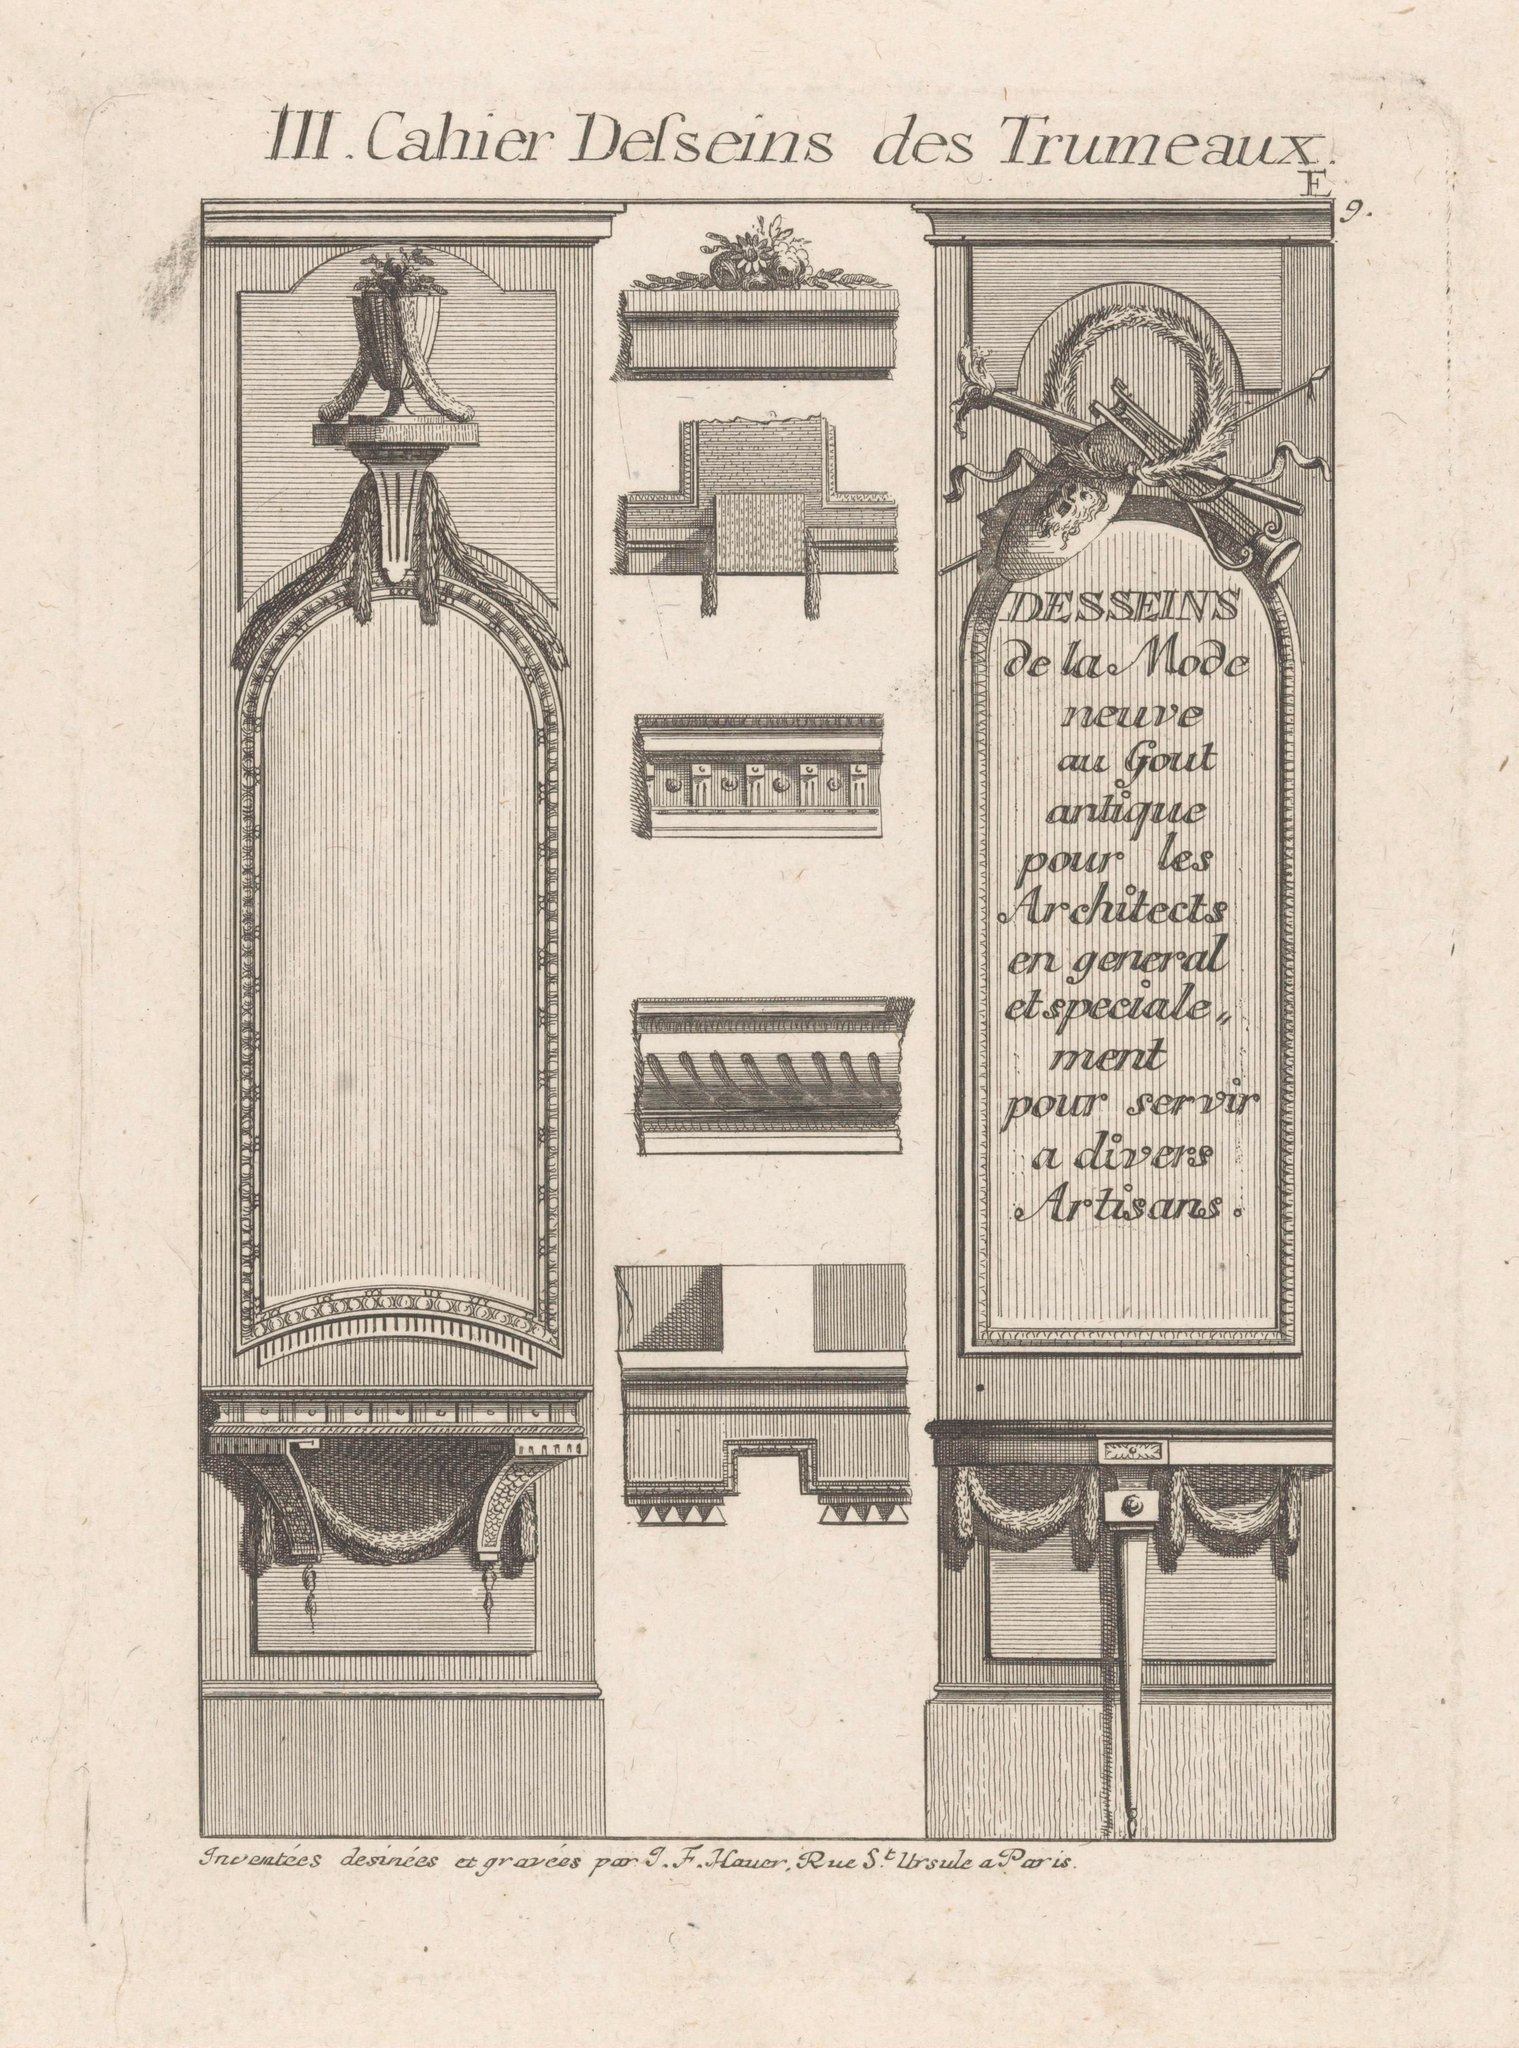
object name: titelprent, frontispice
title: Twee trumeaus en vijf omlijstingen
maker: johann thomas hauer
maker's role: print maker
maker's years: 1748-1820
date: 1781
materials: paper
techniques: engraving, etching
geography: paris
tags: half-column, pilaster ~ architecture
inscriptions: collector's mark: Lugt 2760, collector's mark: Lugt 2228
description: Ontwerpen voor twee trumeaus met tafels, panelen, guirlandes, een vaas, een muziekinstrument, schild en lauwerkrans. In het midden vijf ontwerpen voor omlijstingen.